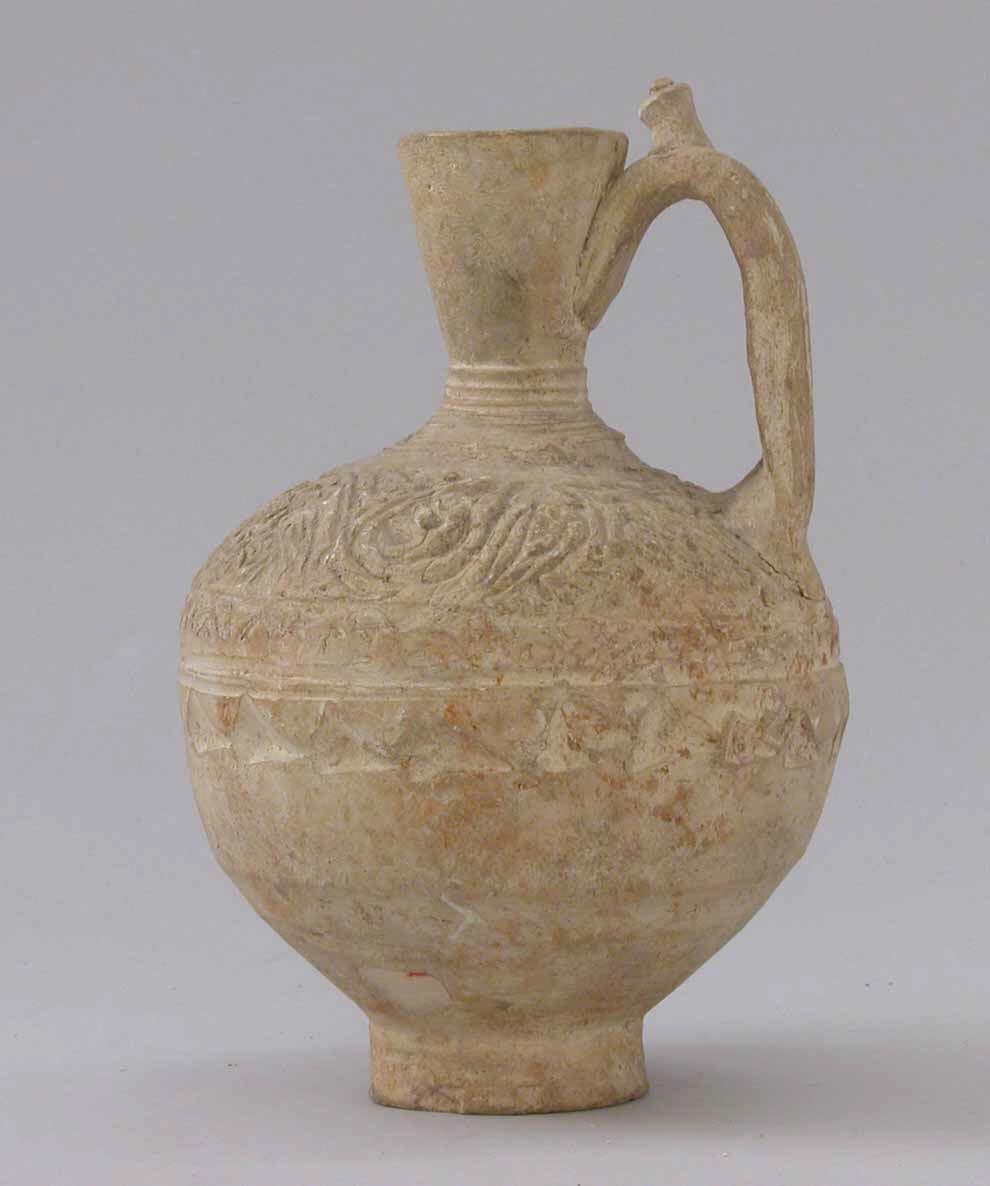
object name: ewer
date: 1001-1200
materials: earthenware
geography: syria